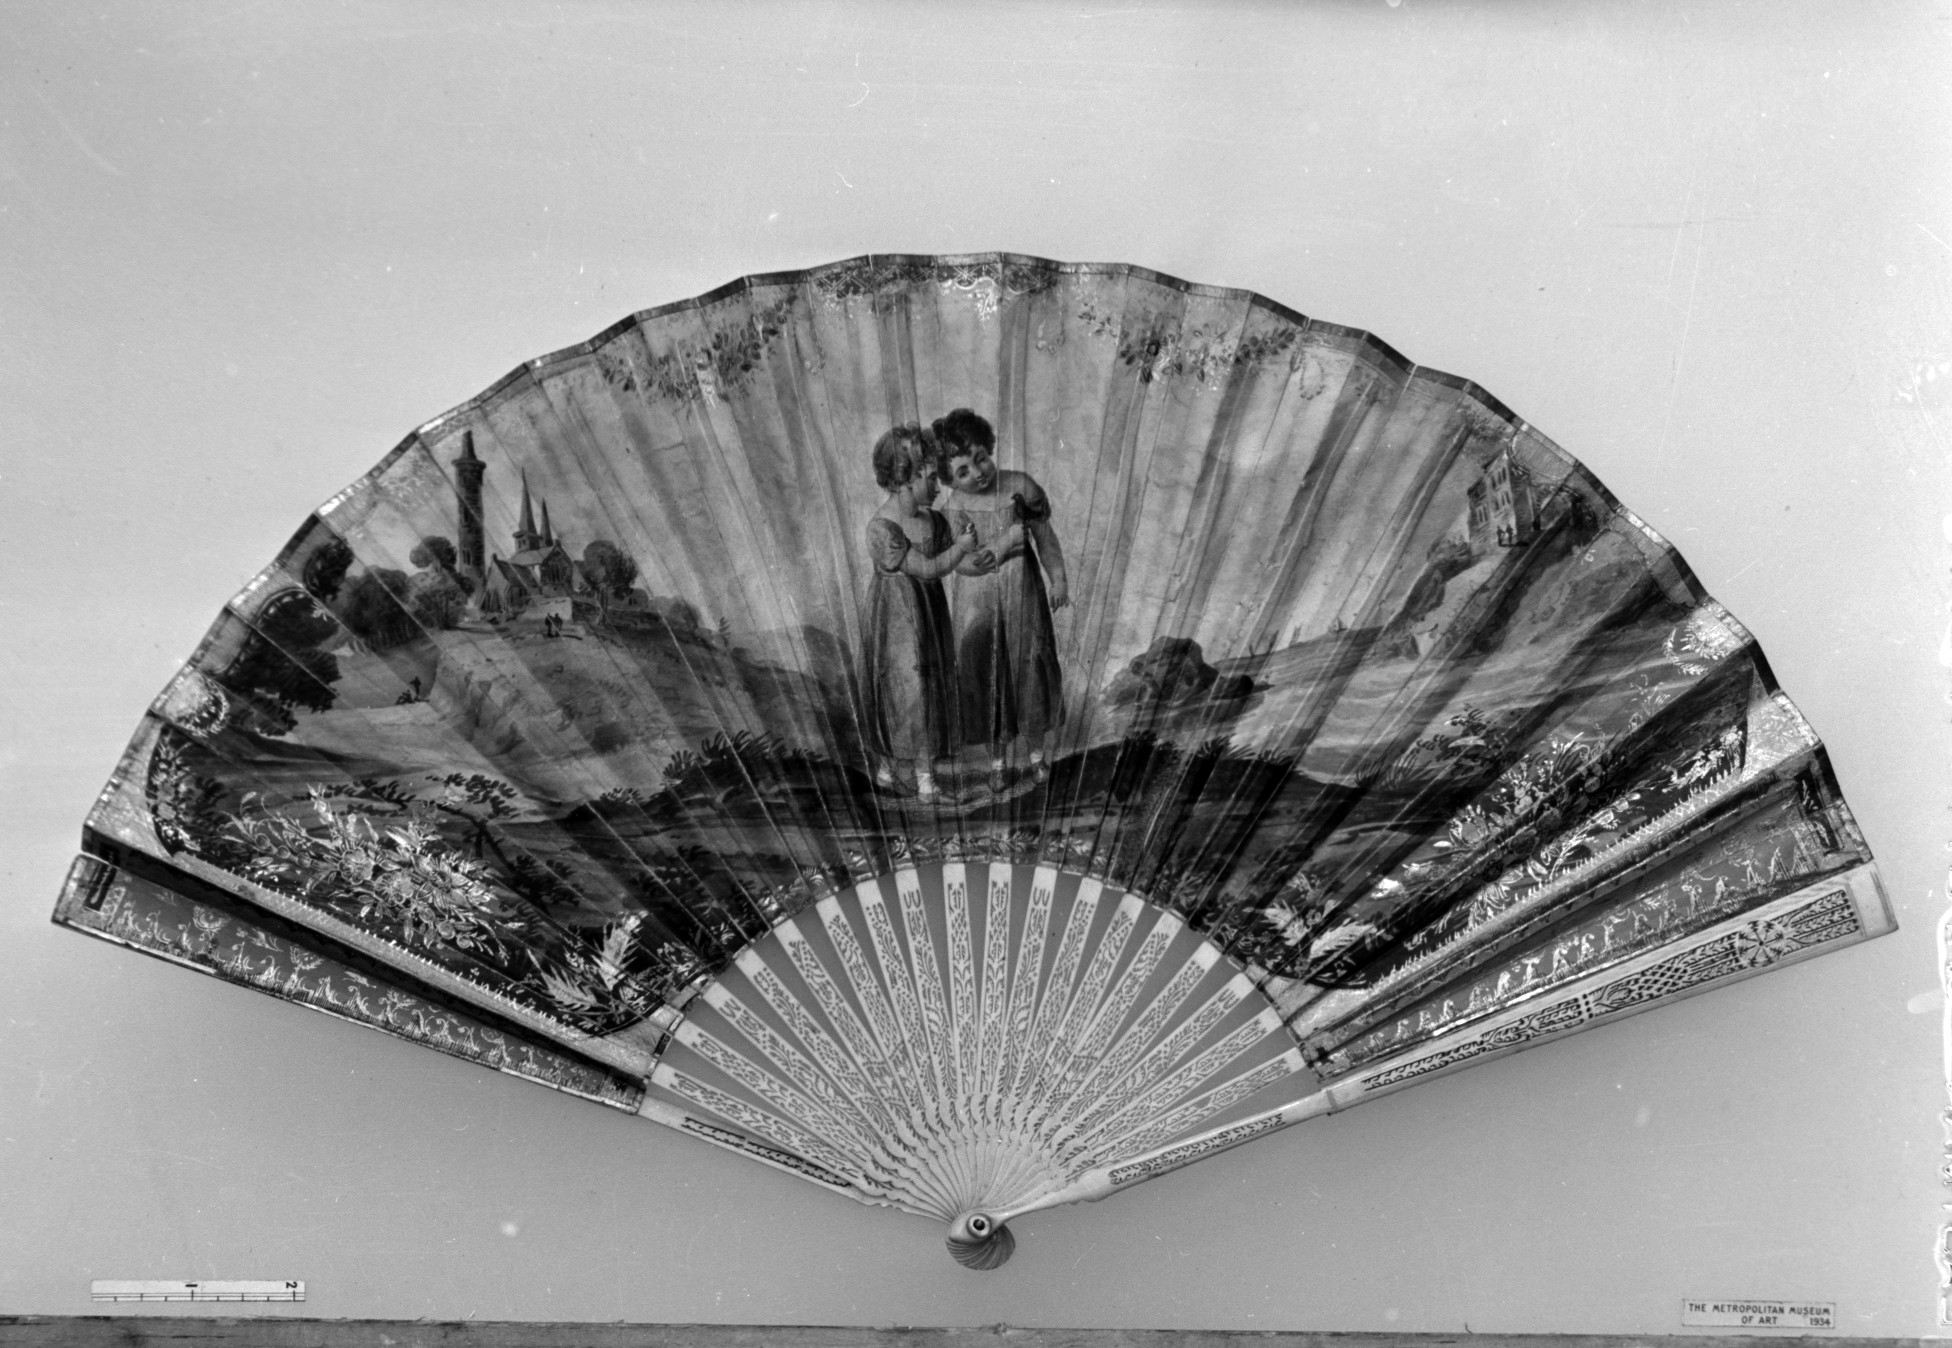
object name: fan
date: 1815-1830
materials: gilt, ivory, mother of pearl, paper, skin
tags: girls,landscapes